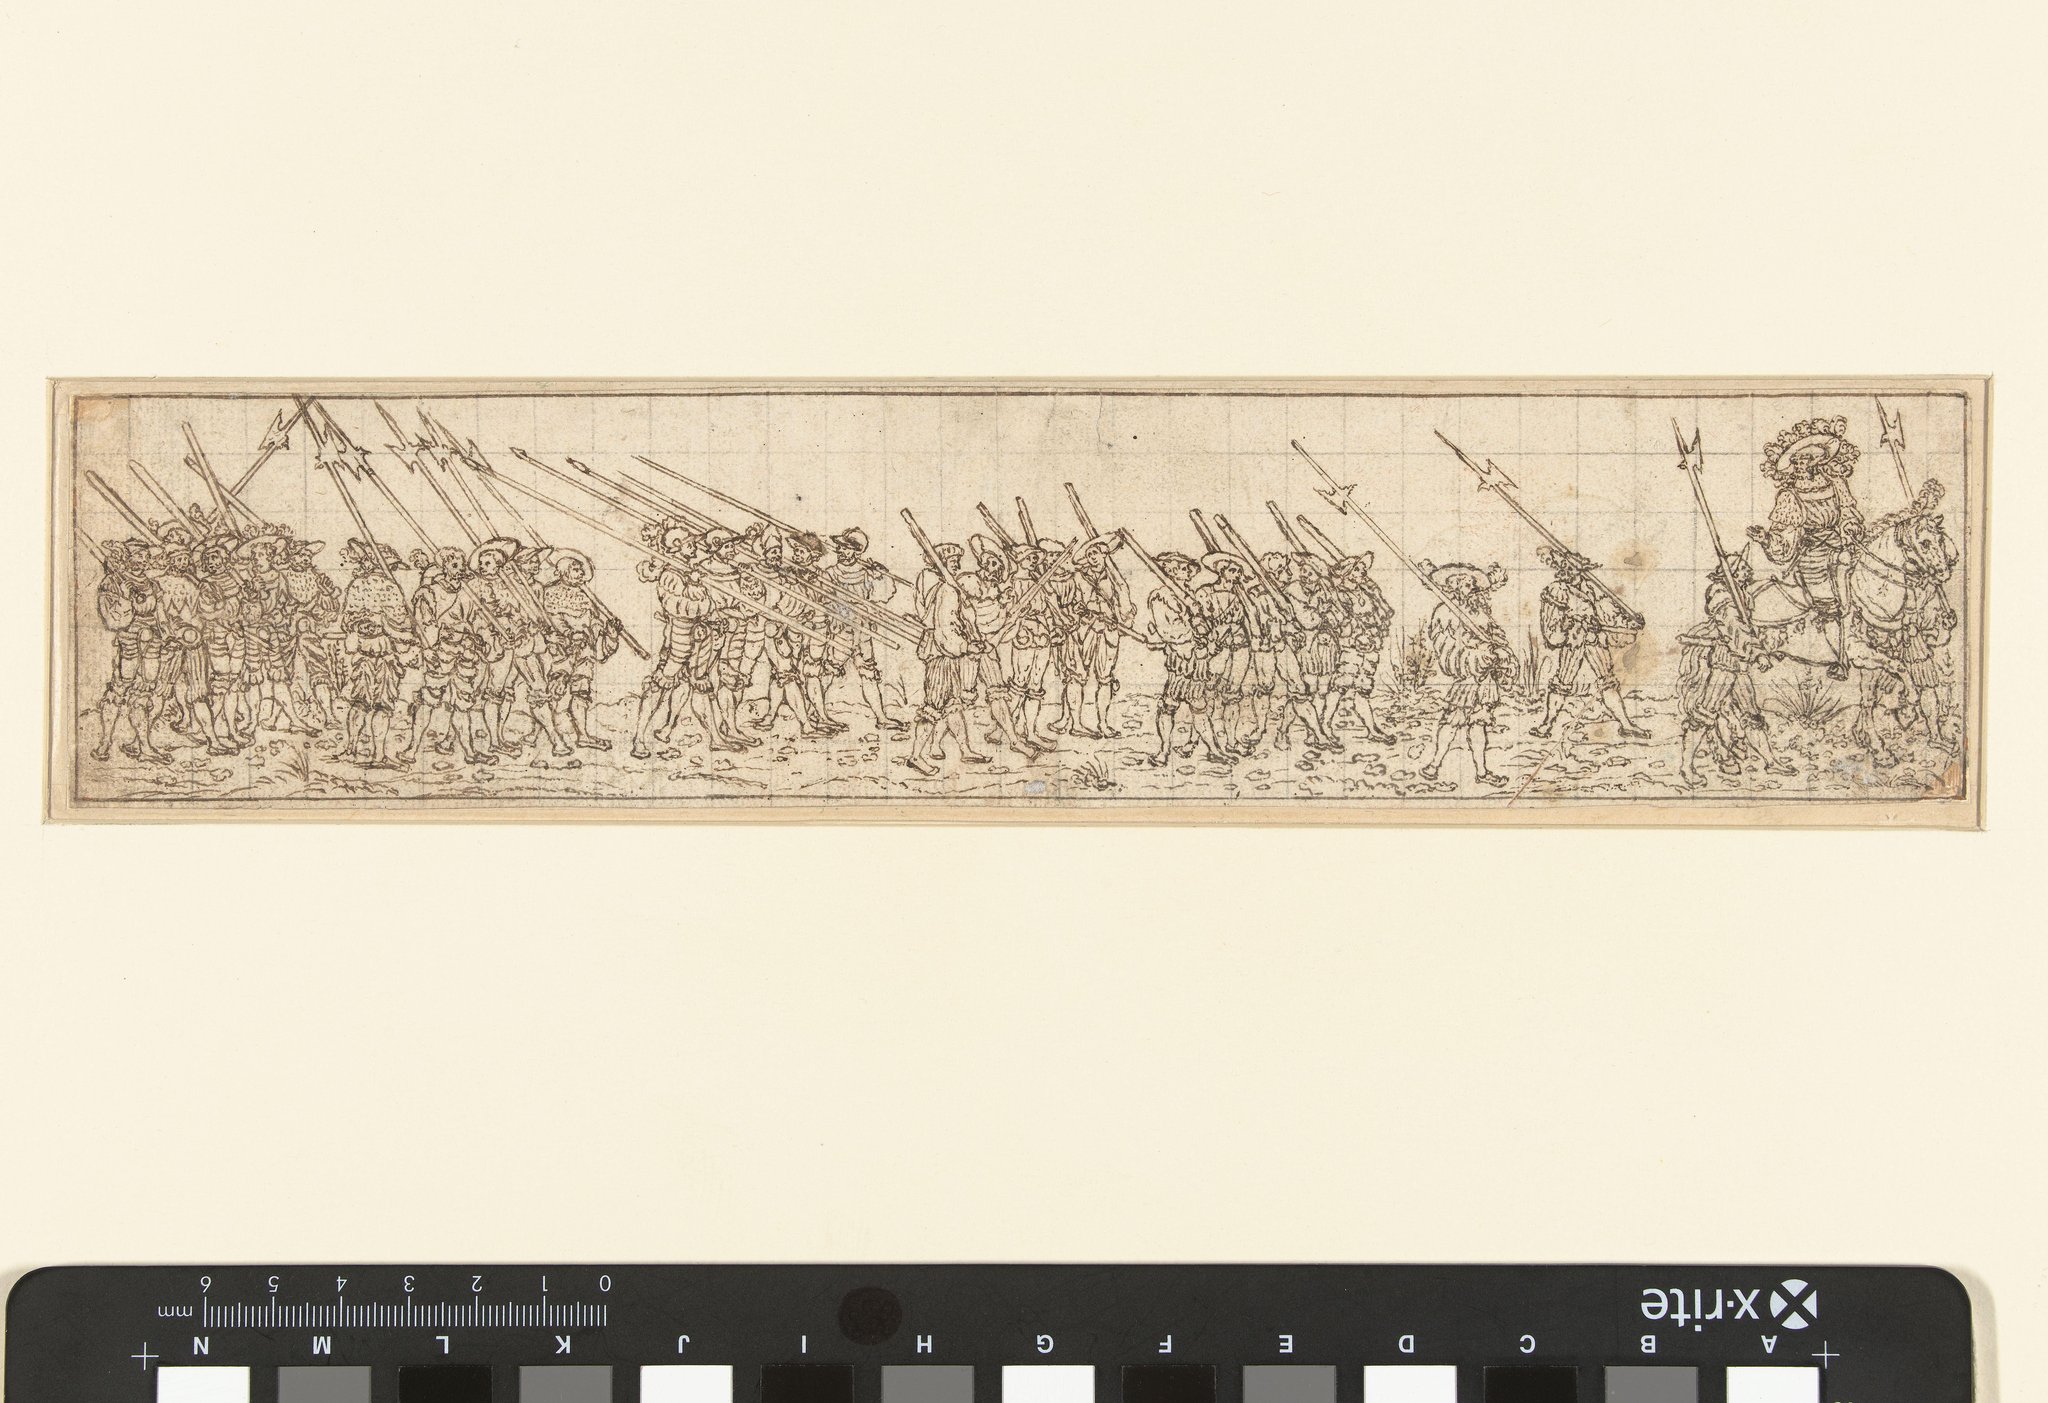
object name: drawing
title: Optocht van musketiers, hellebaardiers en lansdragers, voorafgegaan door een ruiter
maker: hans sebald beham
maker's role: designer, draughtsman, print maker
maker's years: 1500-1550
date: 1510-1550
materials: ink, paper, pencil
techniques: pen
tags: land forces (+ mercenary troops, e.g.: lansquenets), land forces (+ infantry), heating stove